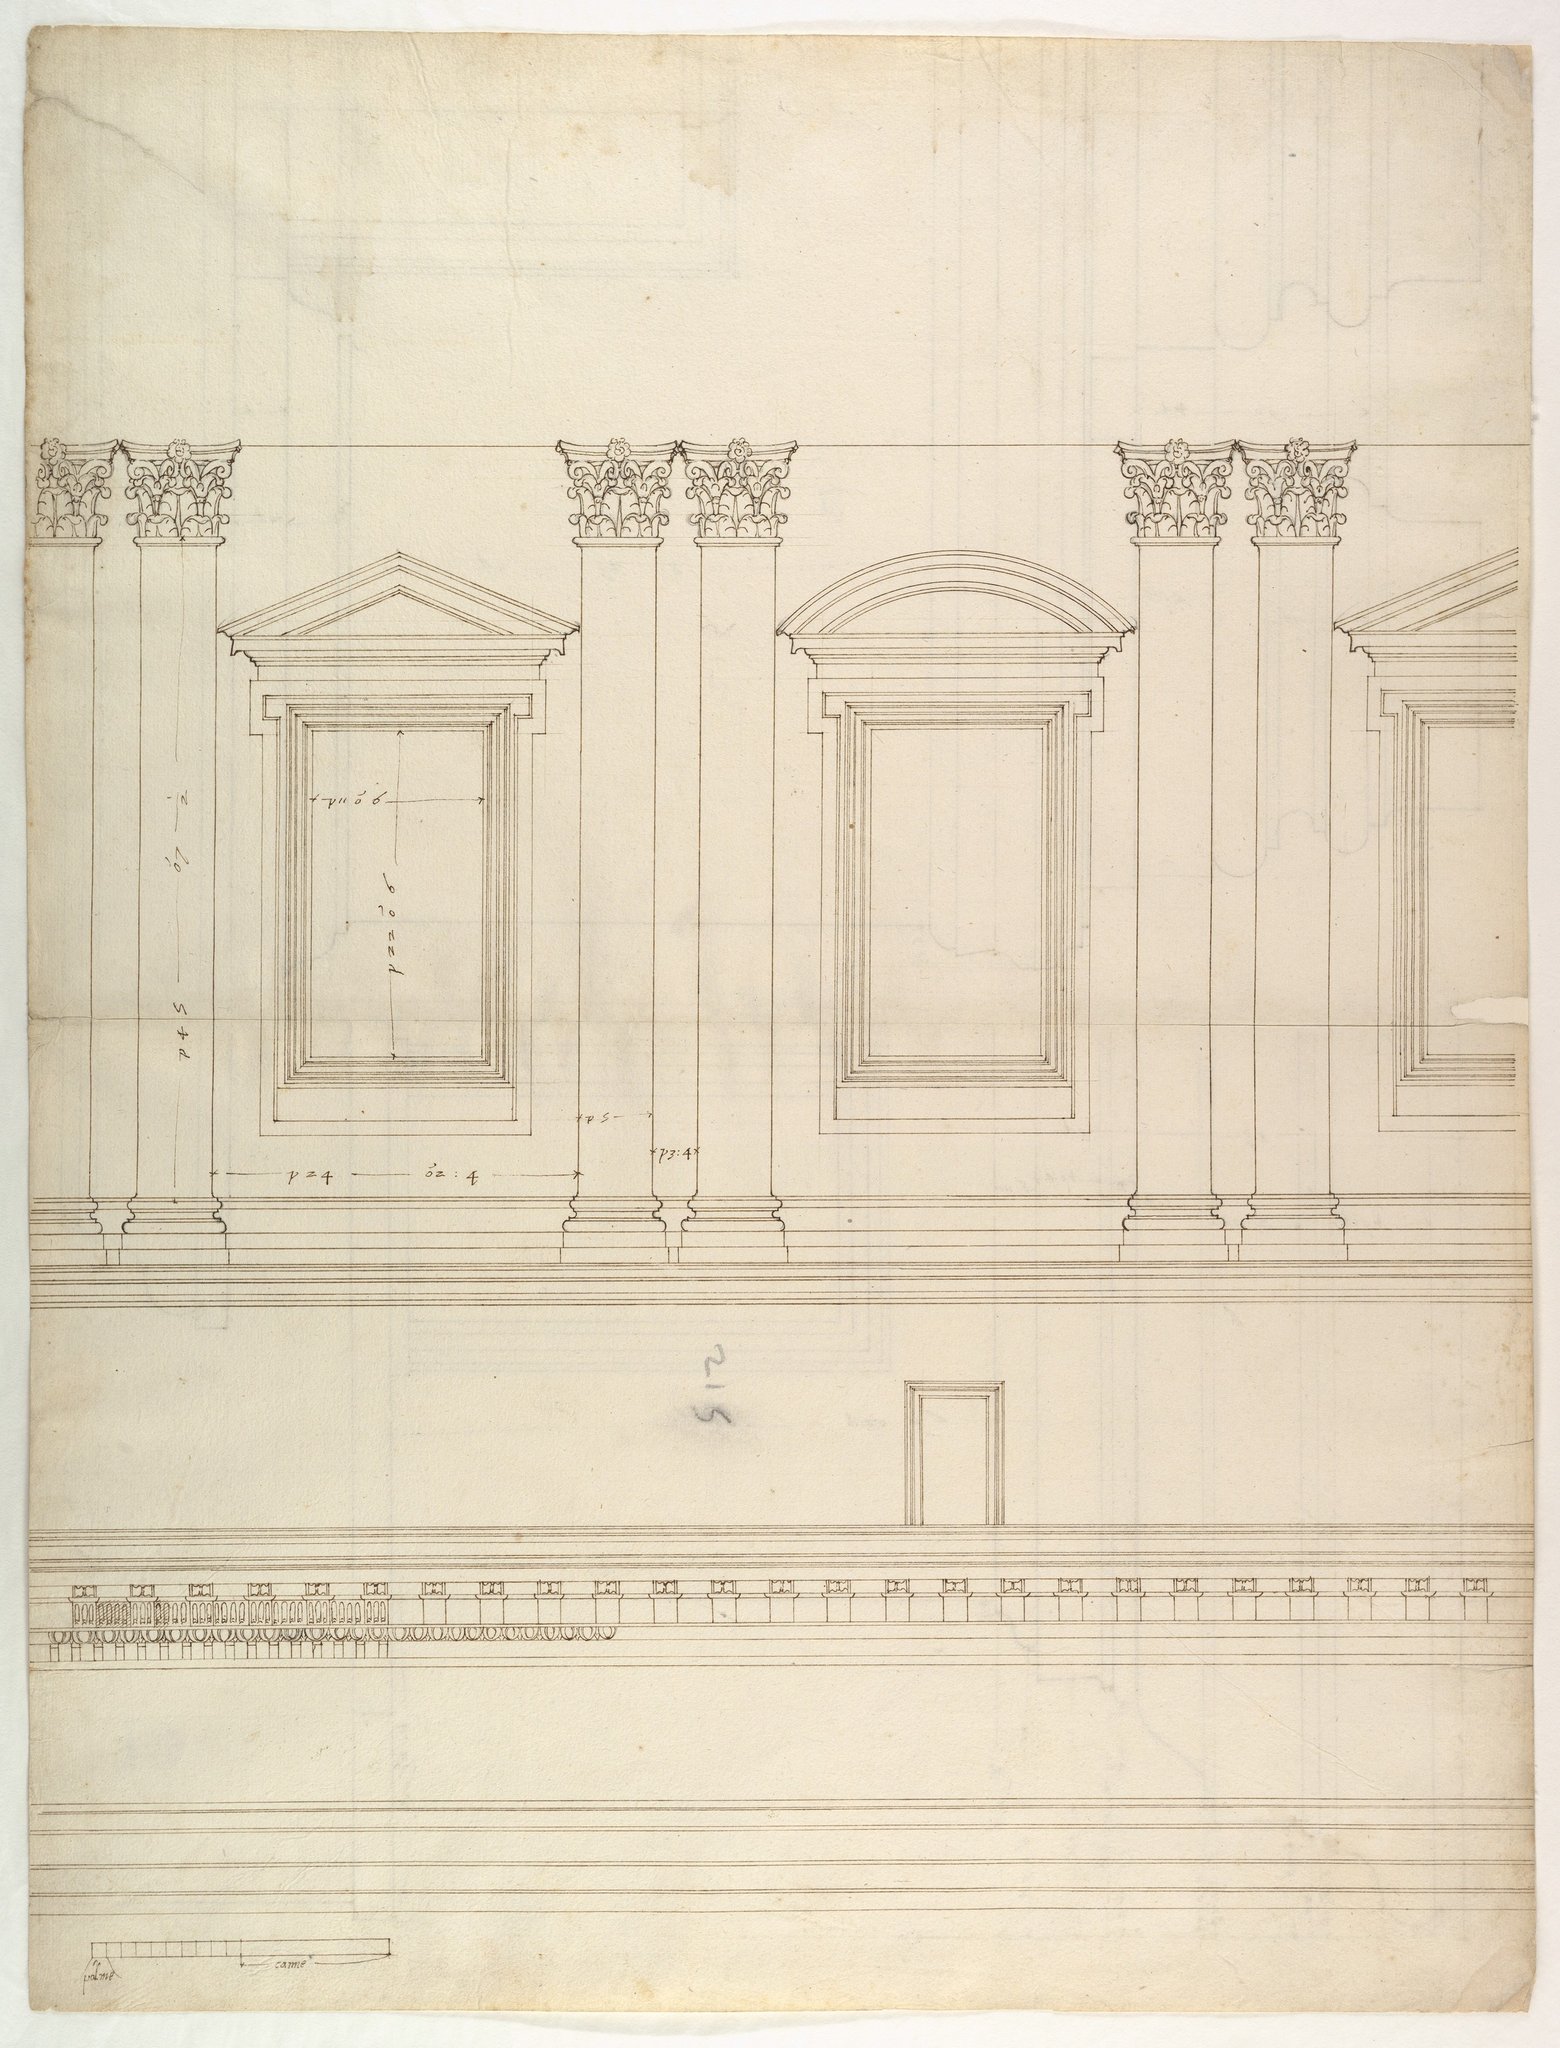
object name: drawing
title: St. Peter's, drum, interior, elevation (recto) St. Peter's, drum, pedestal, section (verso)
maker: etienne dupérac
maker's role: artist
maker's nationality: french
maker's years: 1535-1604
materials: chalk, ink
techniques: incising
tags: architecture